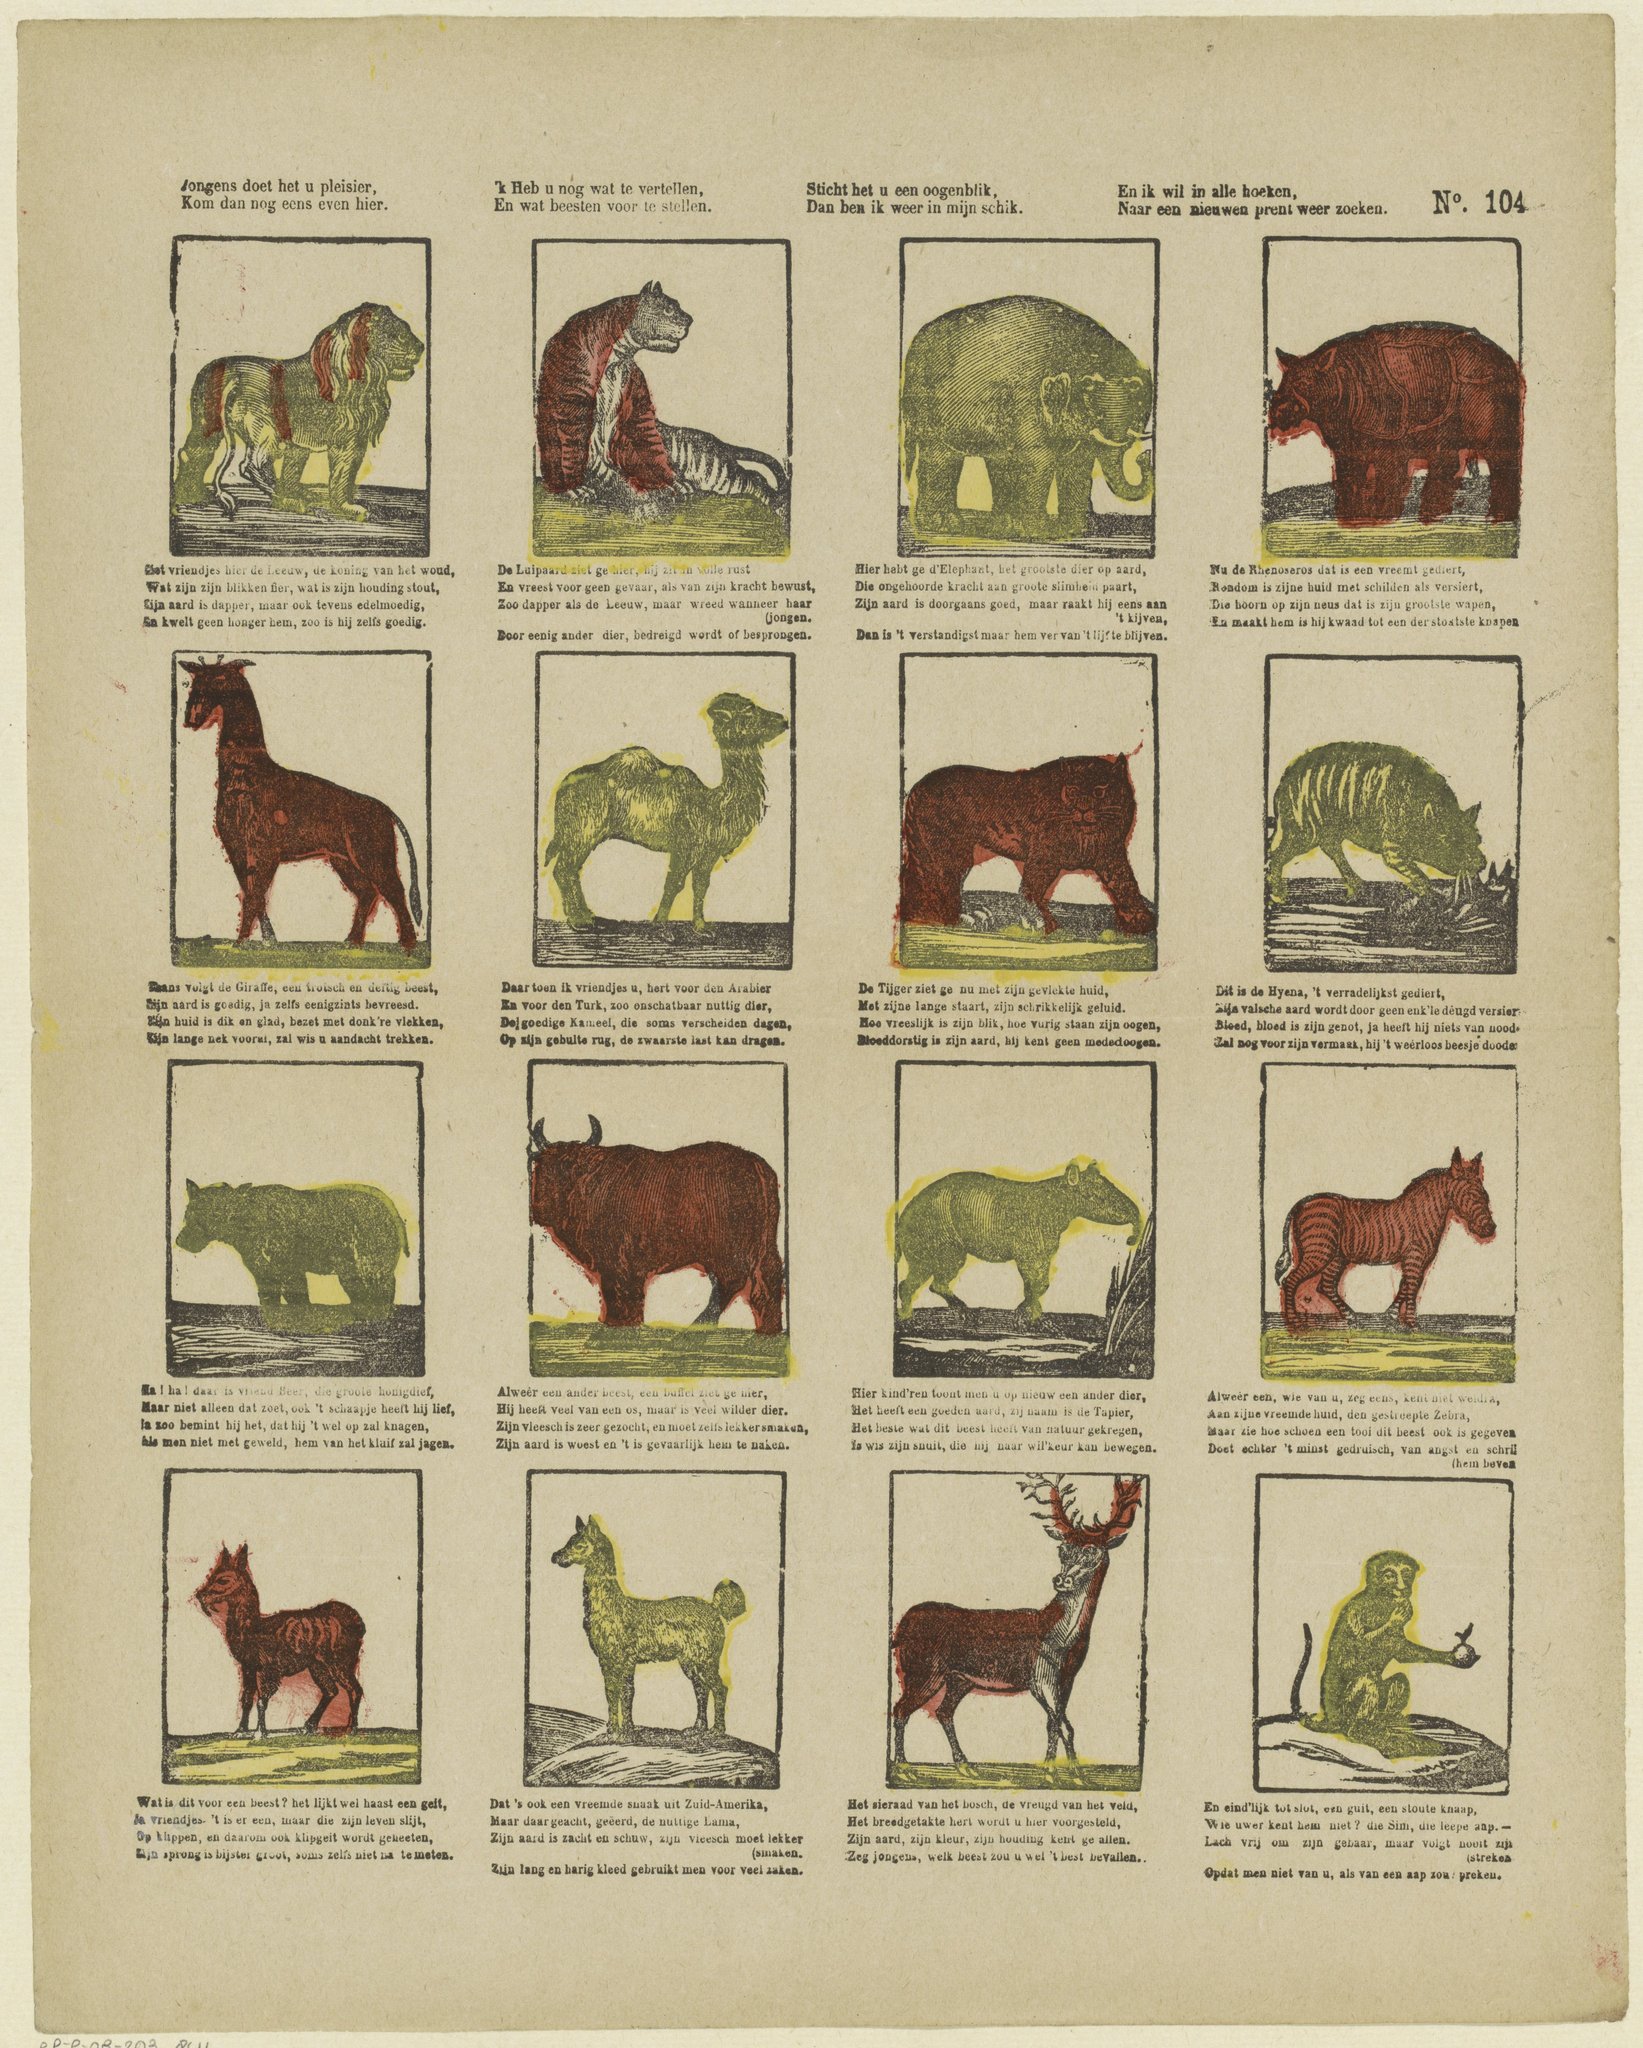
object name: print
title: Dieren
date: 1827-1894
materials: paper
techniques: colour, letterpress printing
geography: schaarbeek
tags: beasts of prey, predatory animals: tiger, hoofed animals: dromedary, animals, monkeys, apes, hoofed animals: rhinoceros, beasts of prey, predatory animals: lion, trunked animals: elephant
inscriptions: collector's mark: Lugt 2760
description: Blad met 16 voorstellingen van dieren, zoals een leeuw, een tijger, een olifant en een neushoorn. Onder elke afbeelding een vierregelig vers. Genummerd rechtsboven: No. 104.